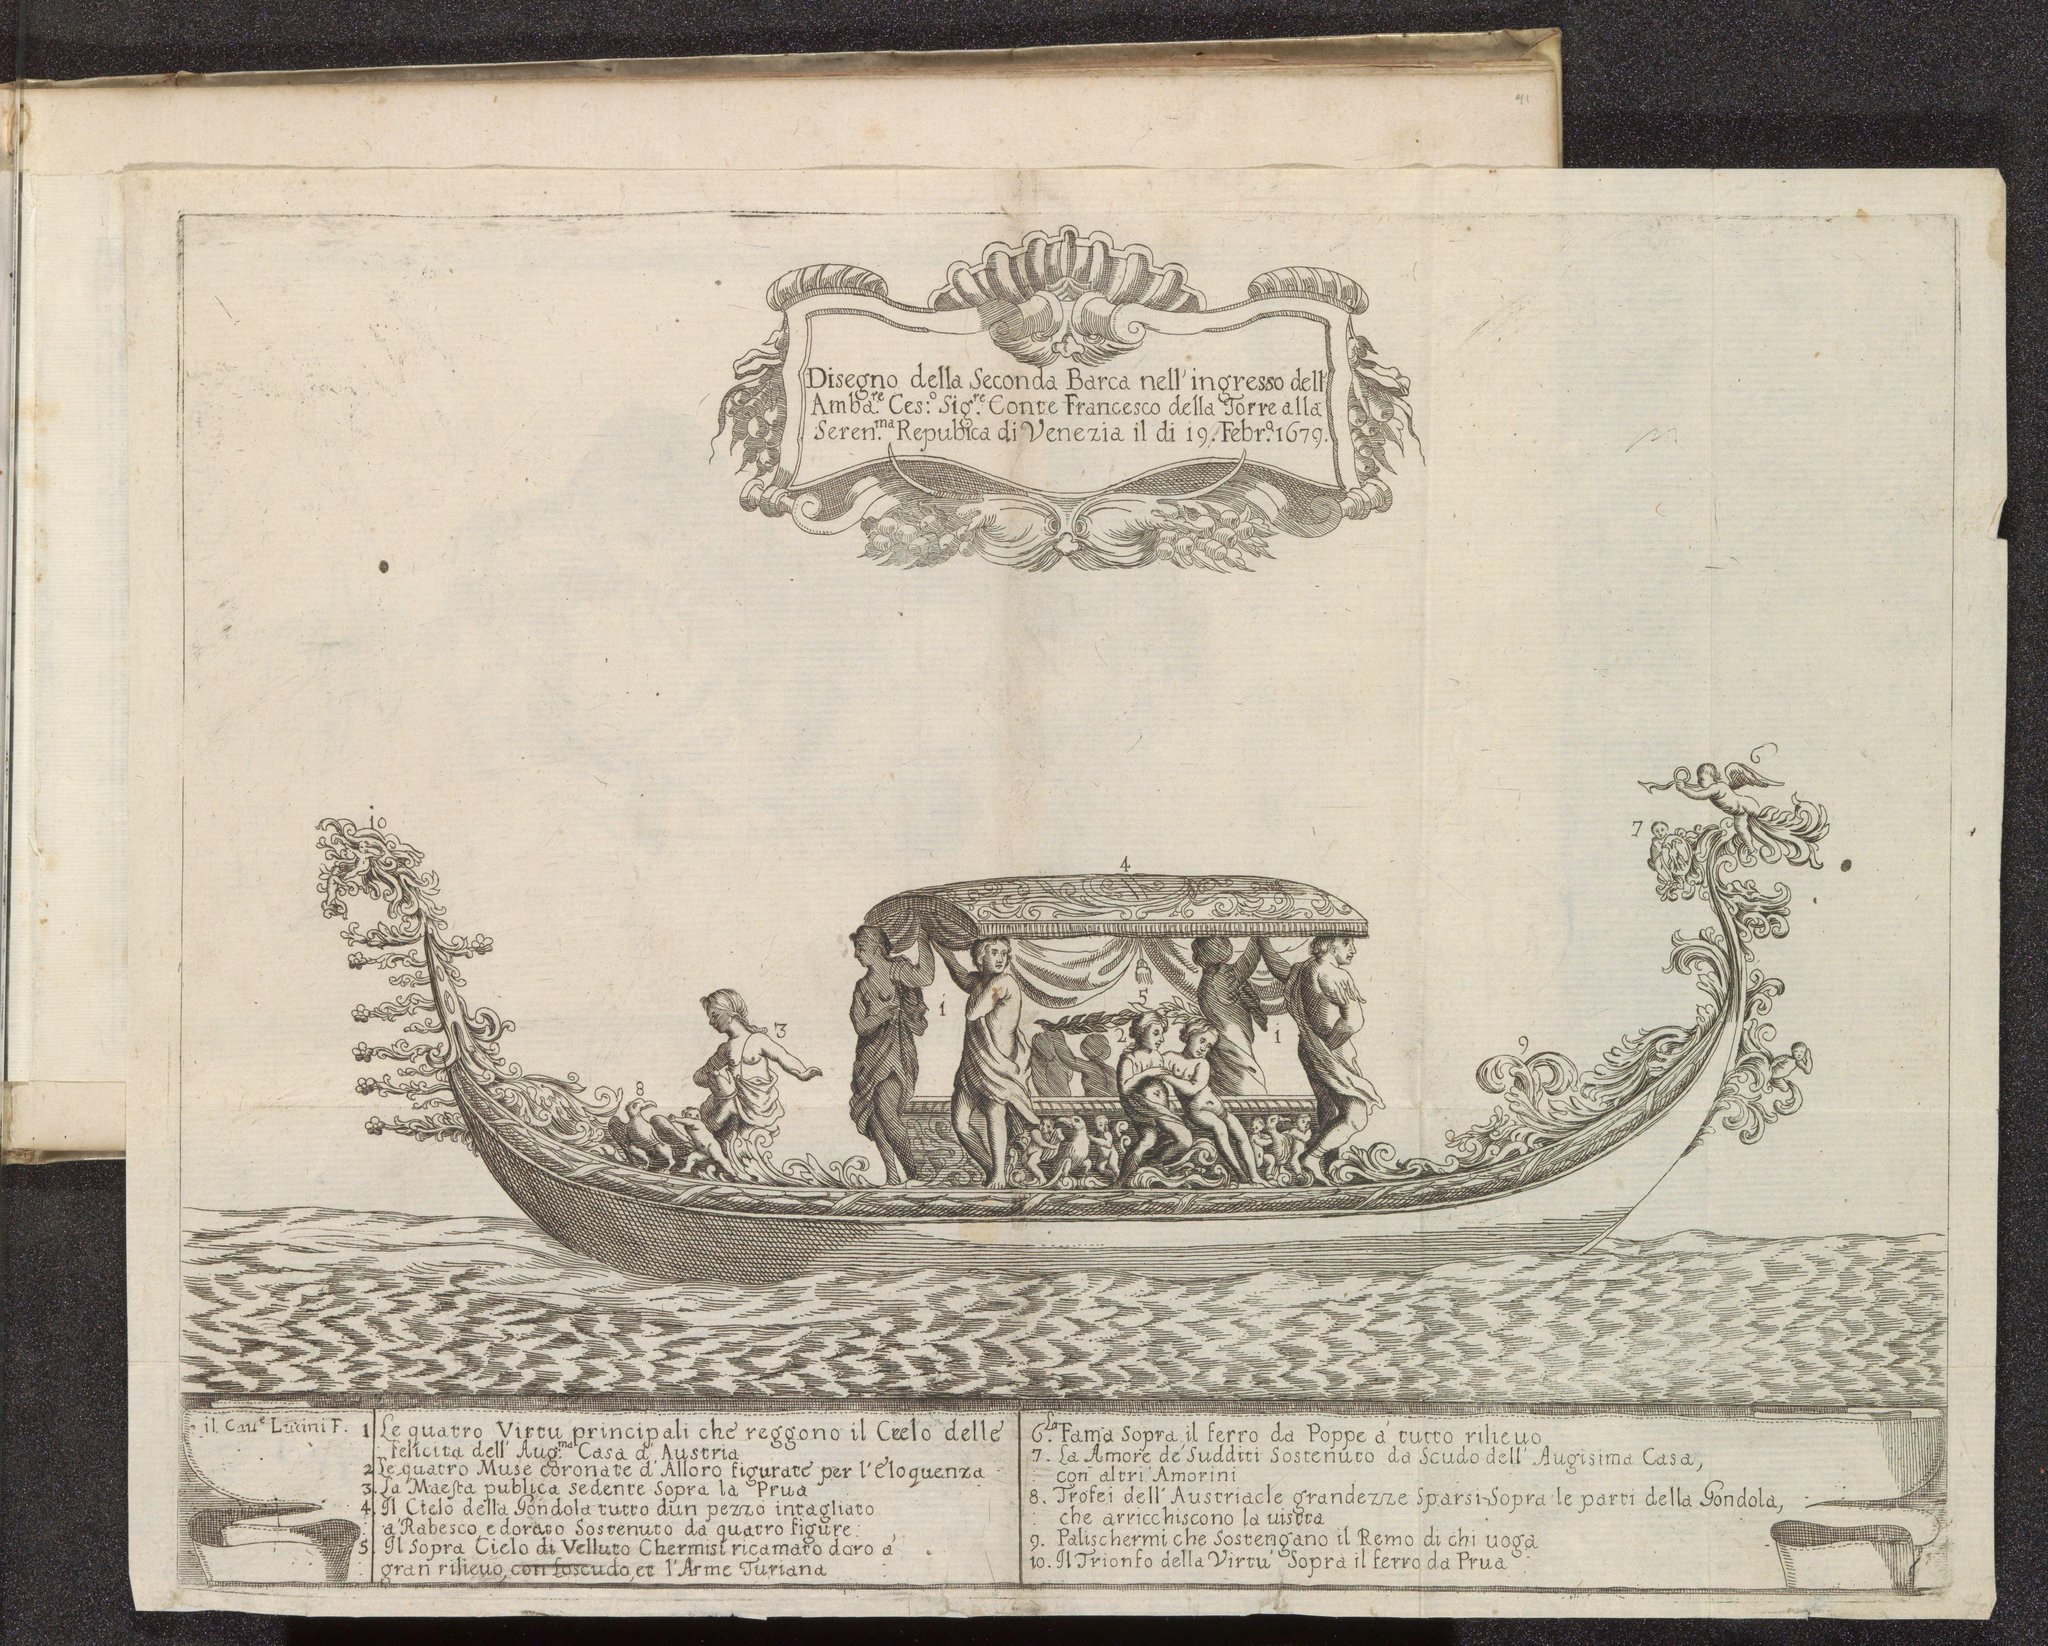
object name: print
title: Gondel met allegorische figuren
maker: antonio francesco lucini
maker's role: print maker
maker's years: 1605-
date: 1679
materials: paper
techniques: engraving, etching, intaglio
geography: italy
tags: gondola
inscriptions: date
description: Geornamenteerde gondel met allegorische figuren. Titel in cartouche midden boven. Verklarende lijst met nummers in ondermarge. Op verso een tekening in bruine inkt van een gezicht van een man met snor en baard. De prent maakt deel uit van een album.